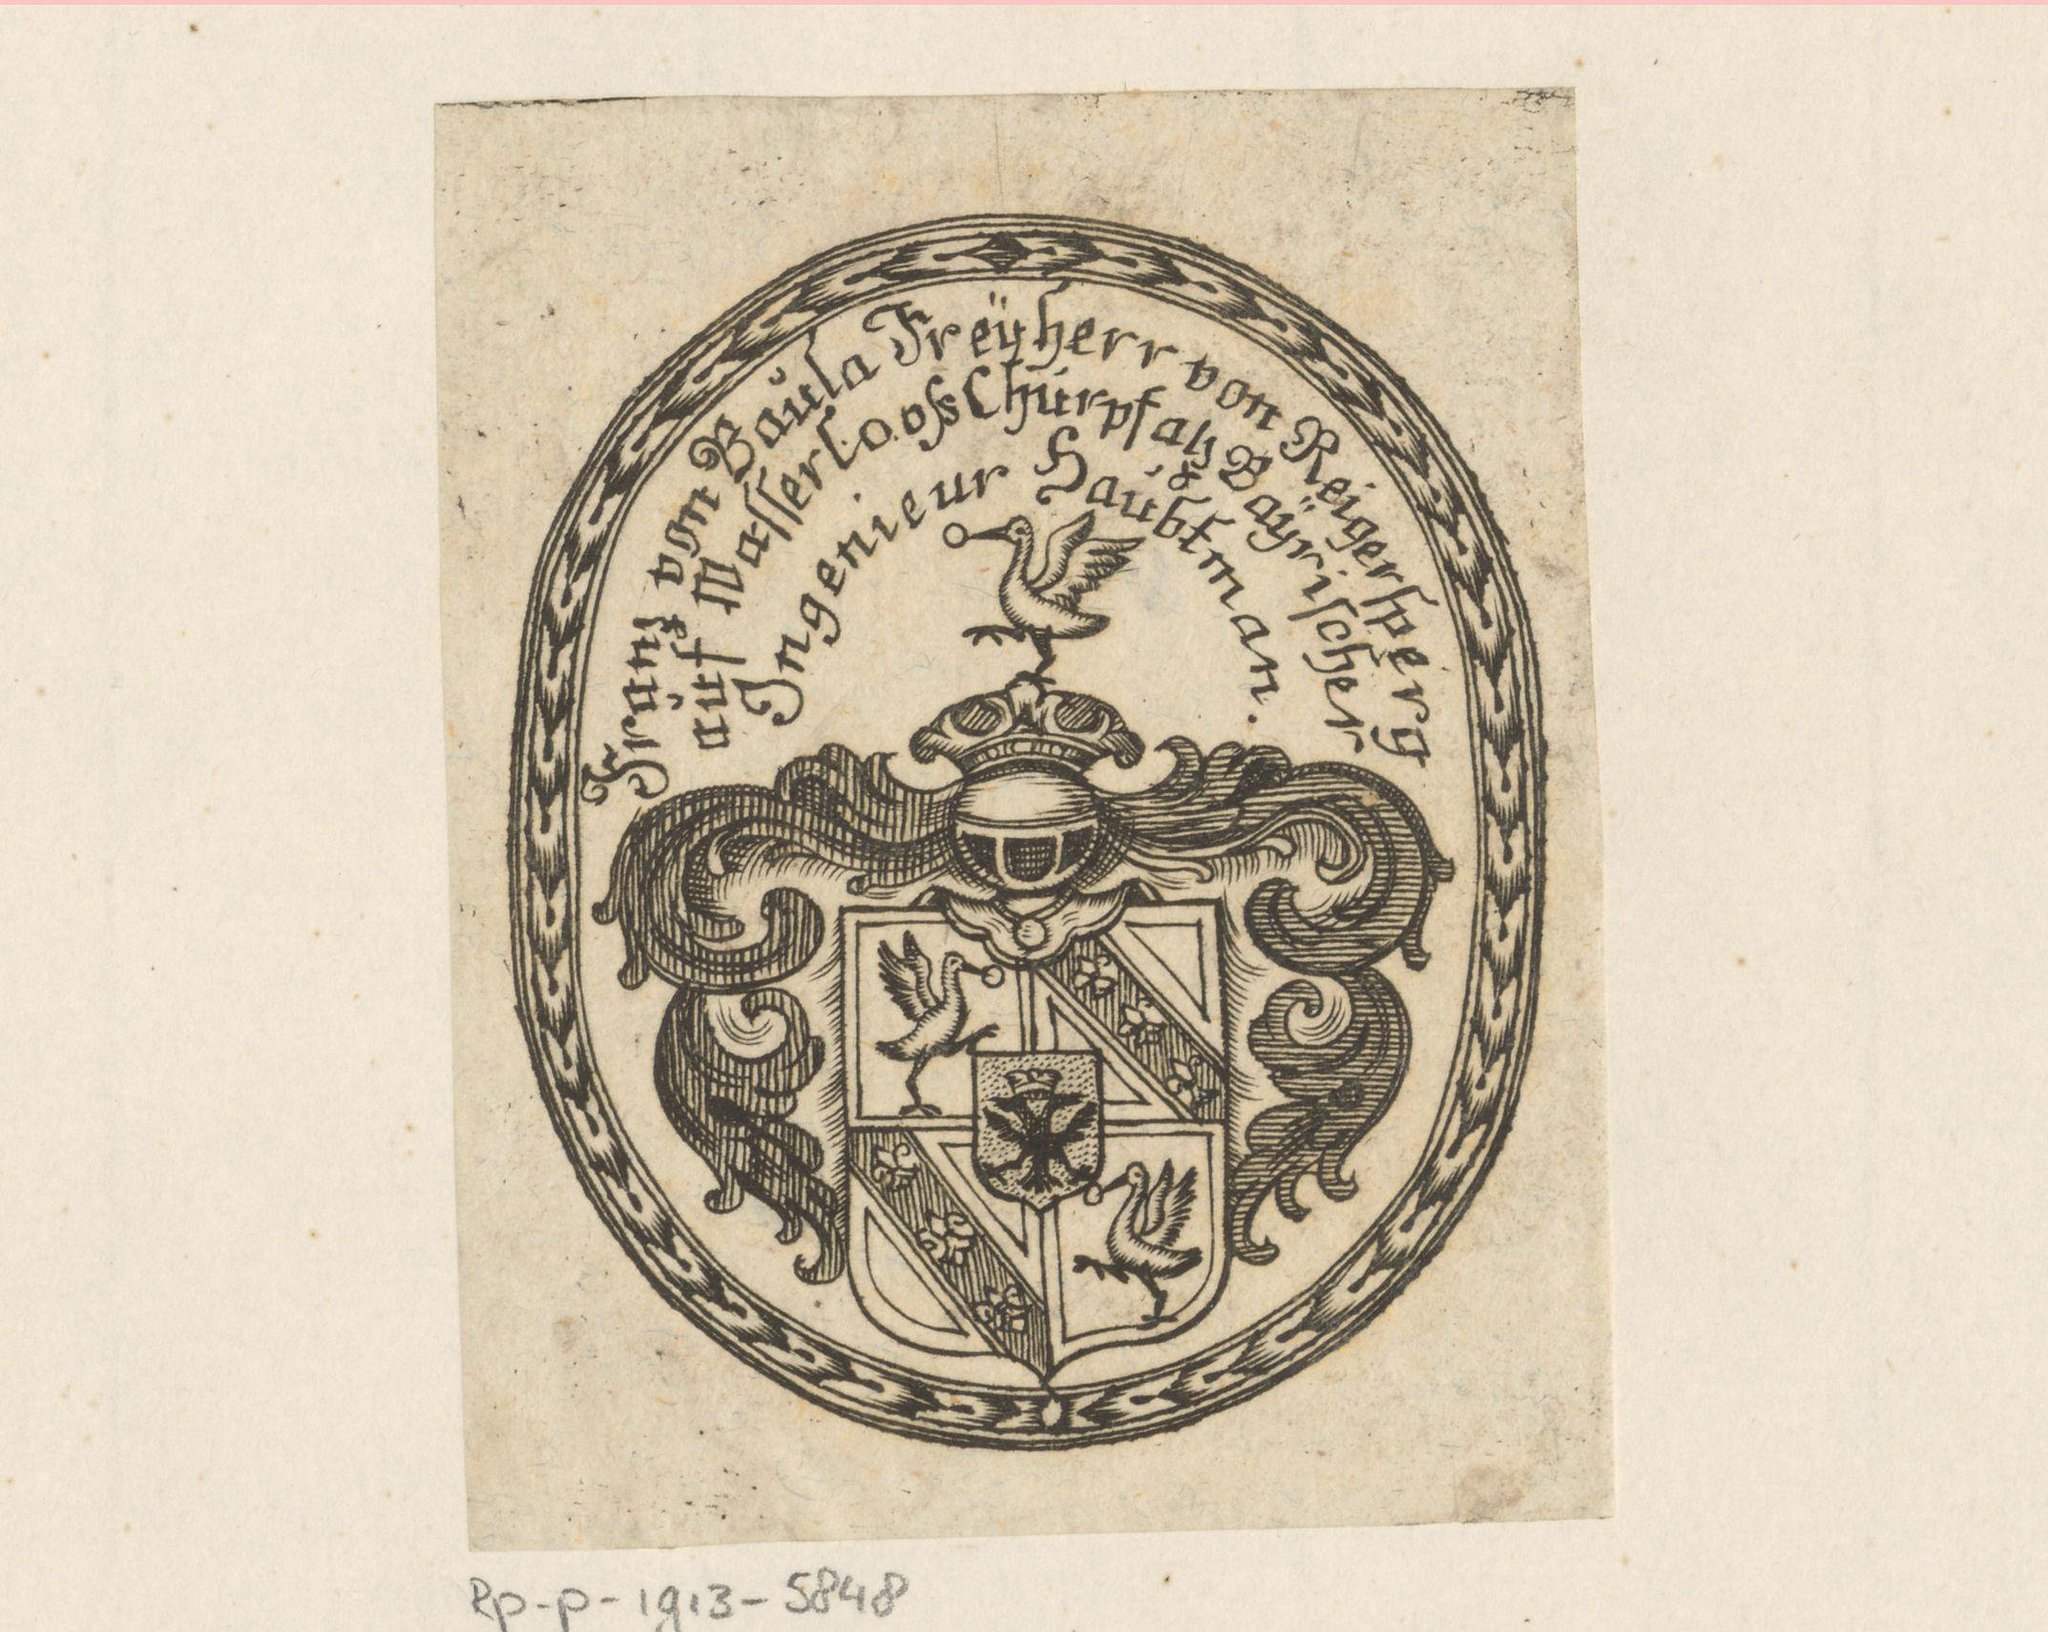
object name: bookplate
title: Ex libris van Frans von Baüla Freijherr von Reigersberg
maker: Anonymous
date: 1650-1799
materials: paper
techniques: engraving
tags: engineer, armorial bearing, heraldry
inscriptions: collector's mark: Lugt 2233, collector's mark: Lugt 2760